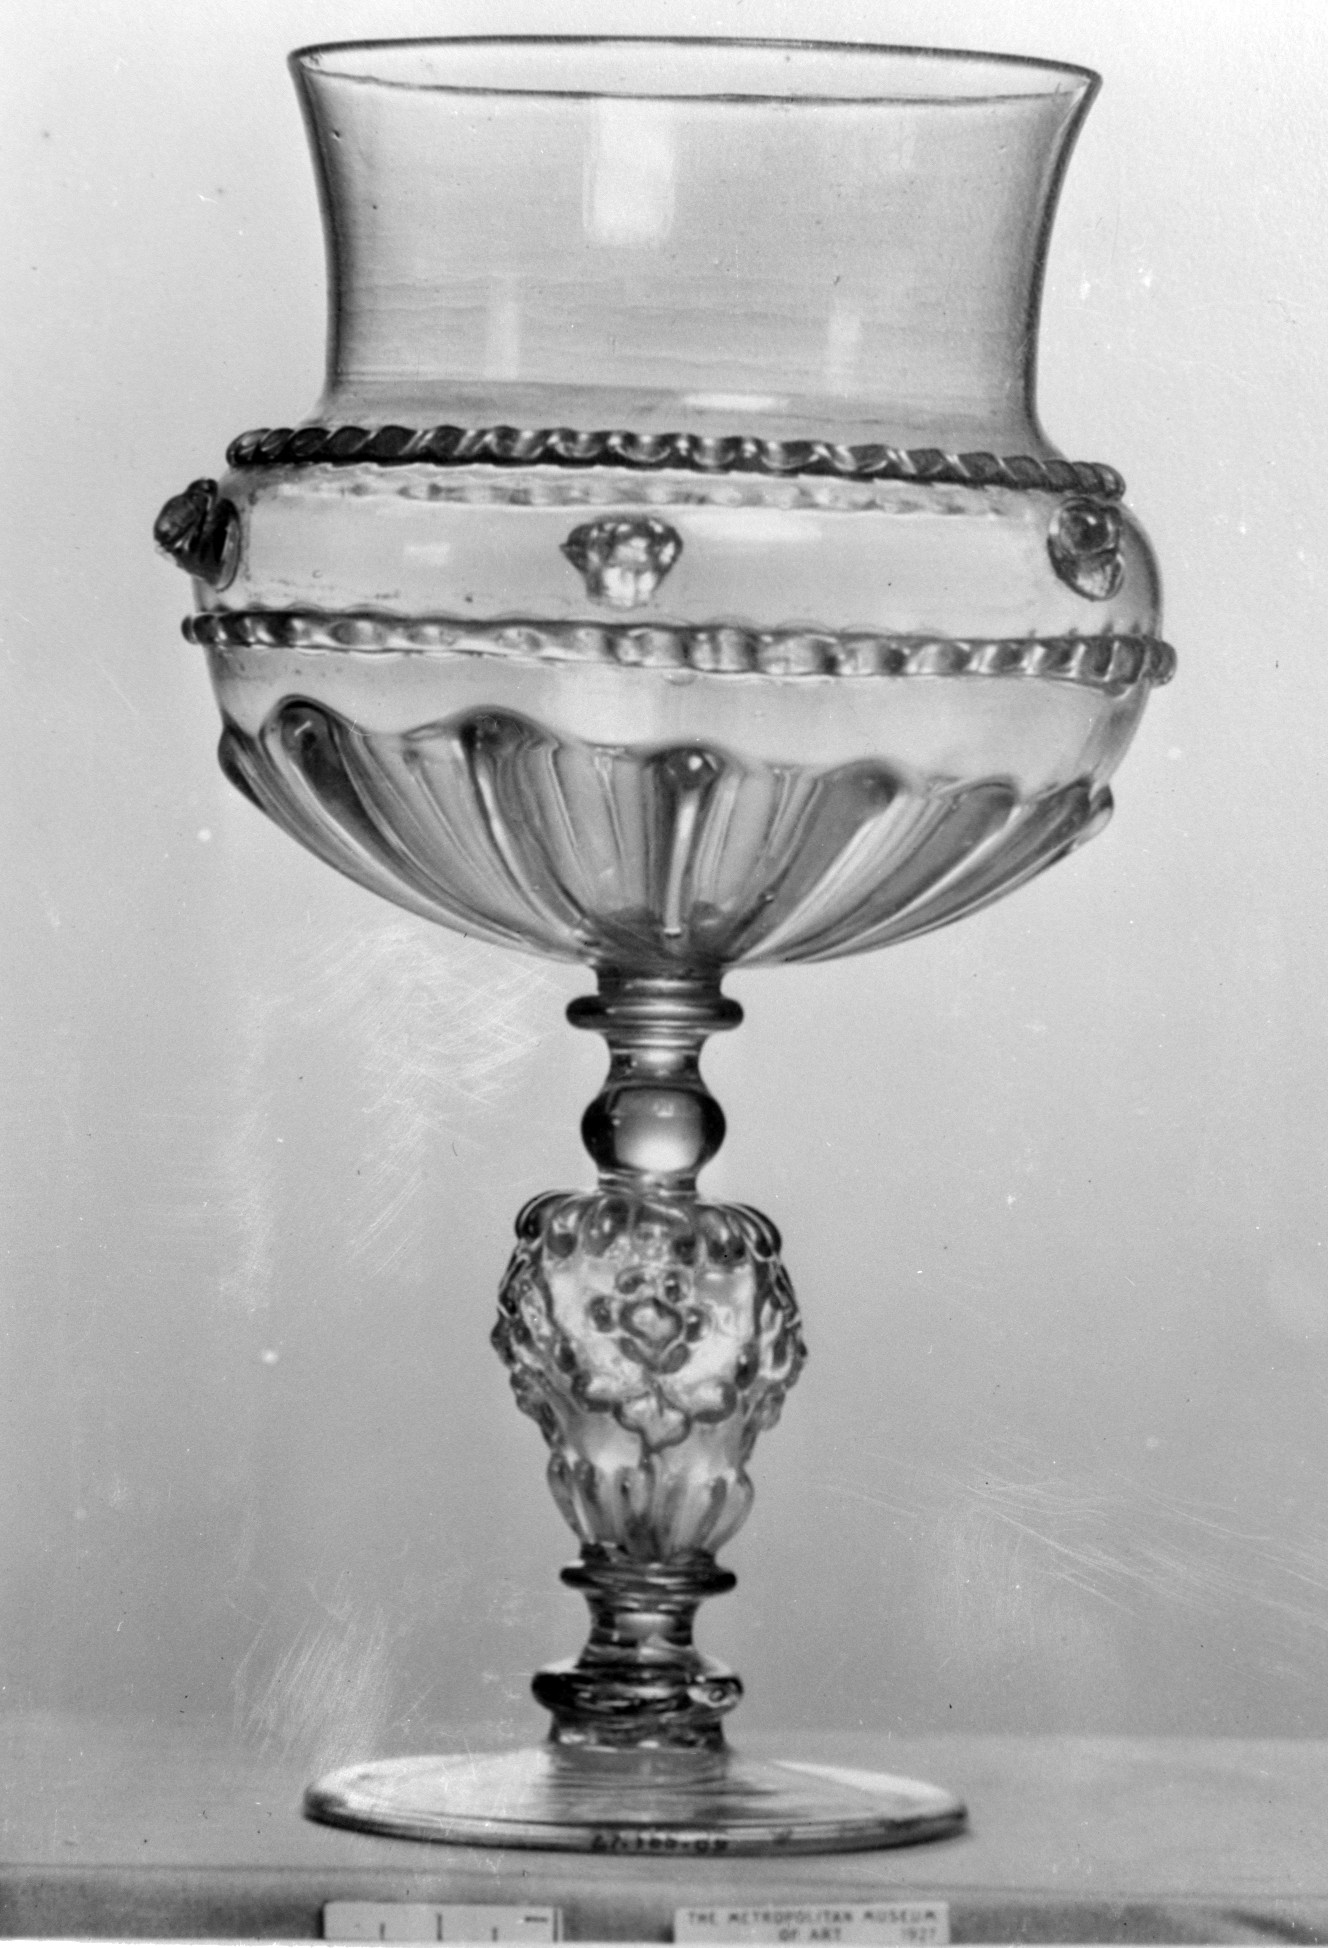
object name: standing cup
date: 1600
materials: glass